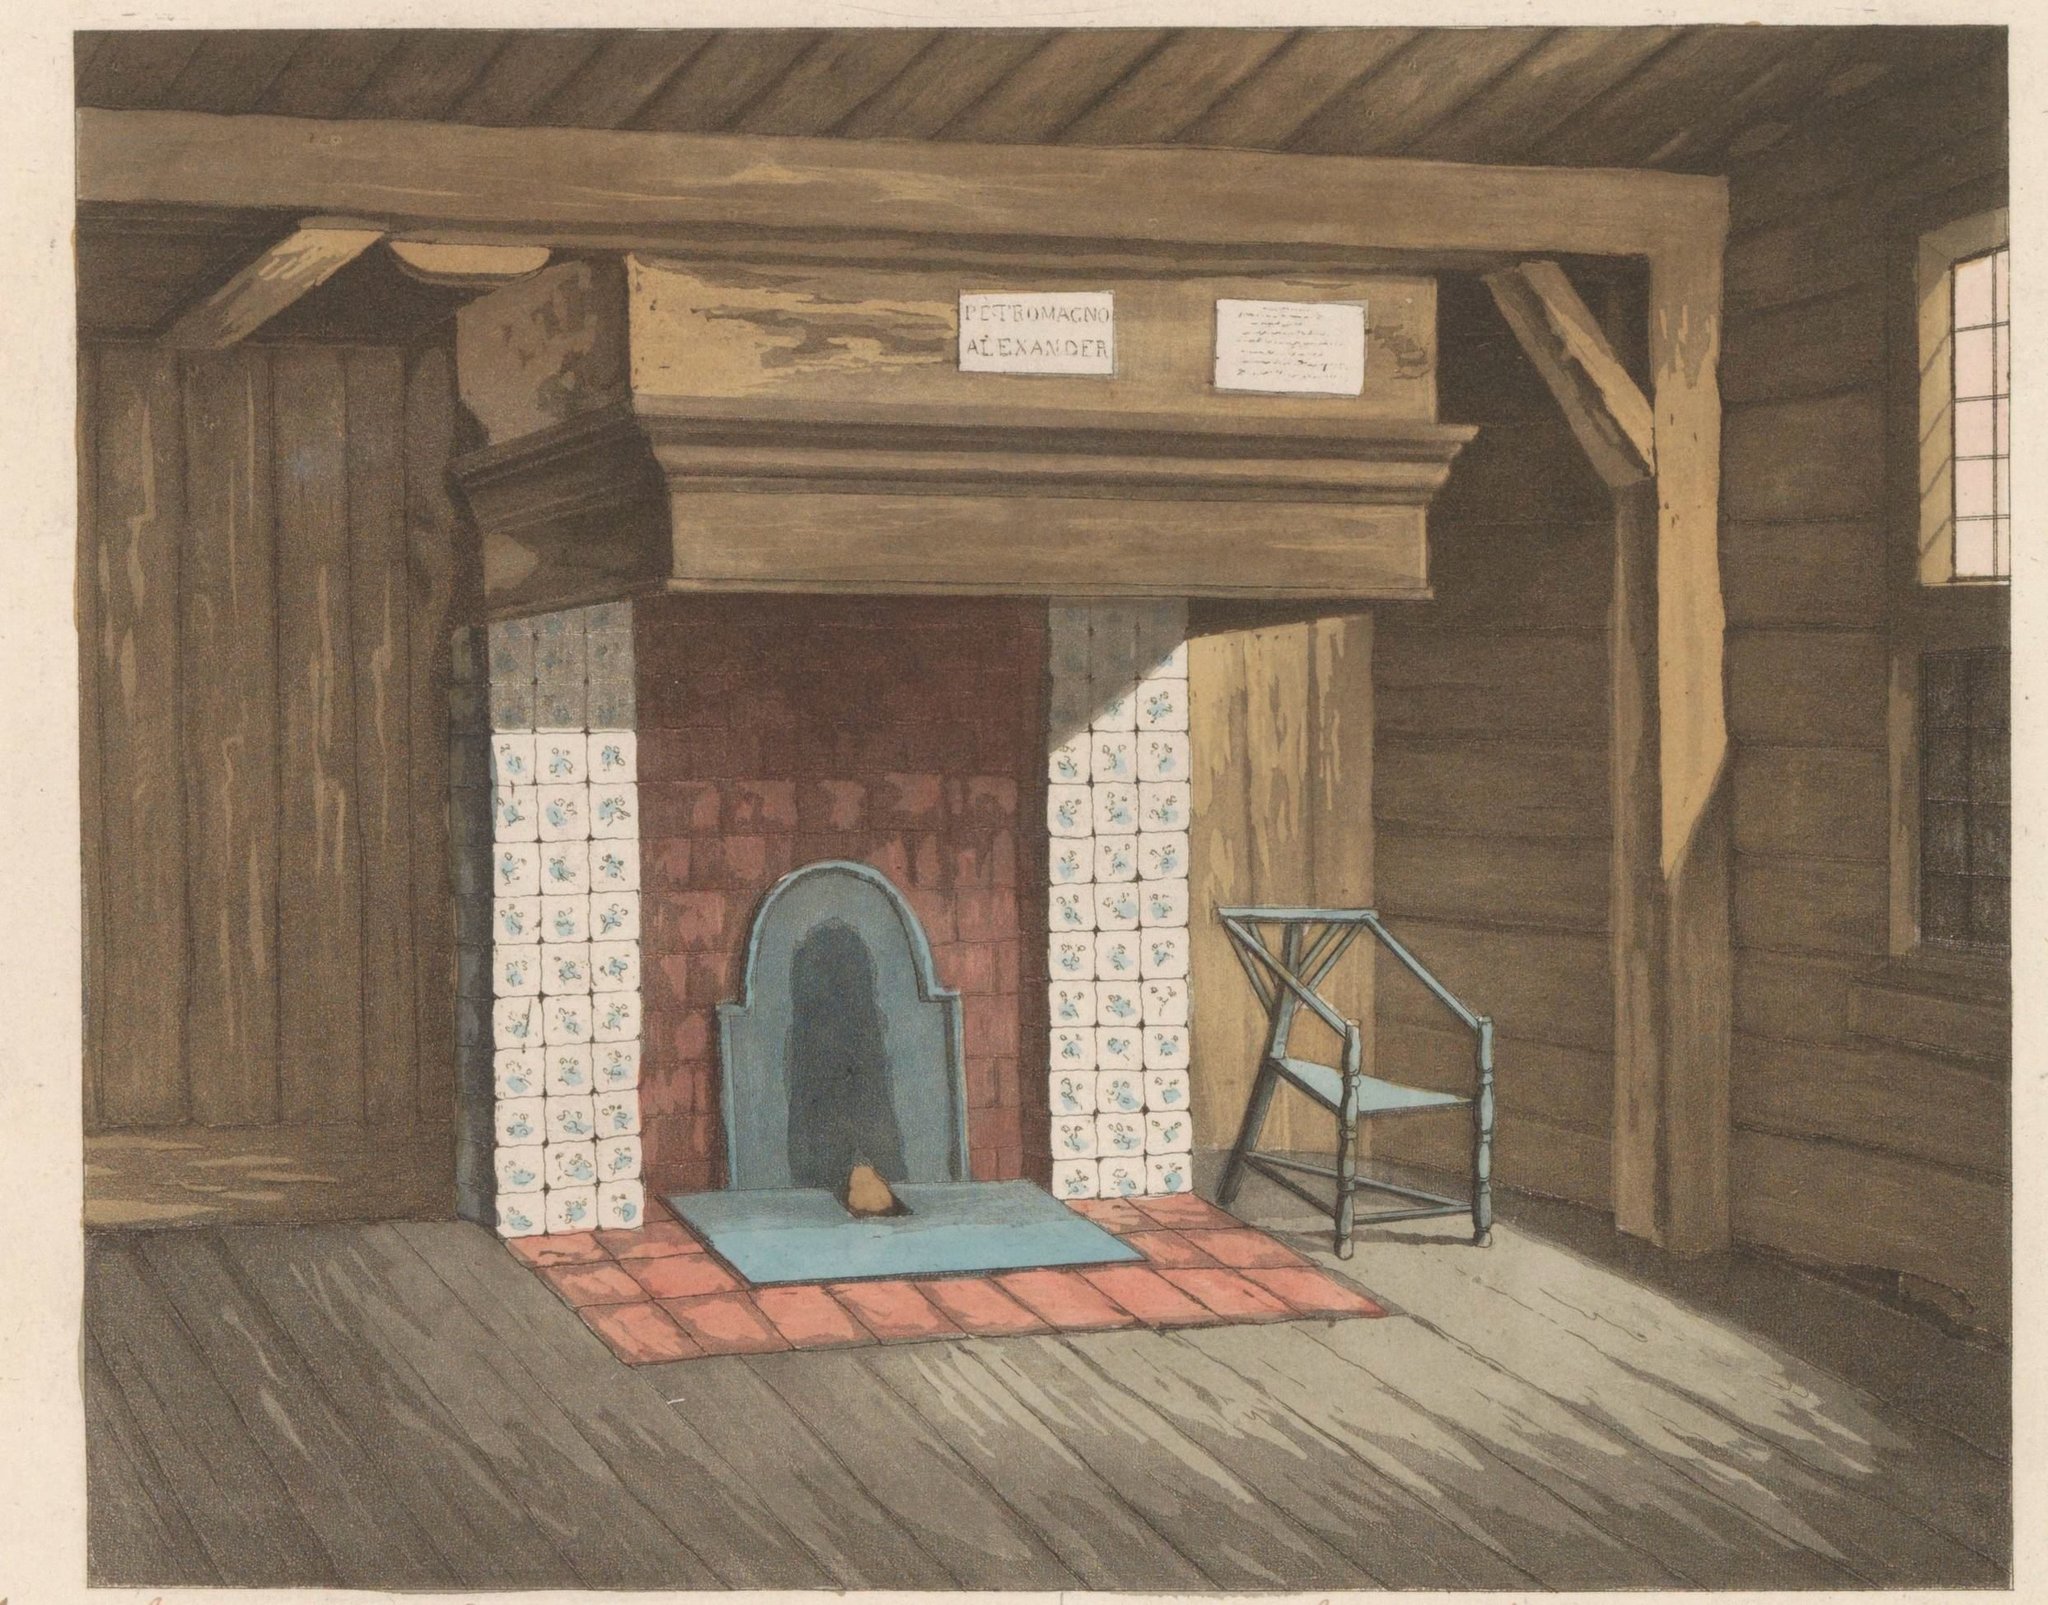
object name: print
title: Het huisje bewoond door Czaar peeter de groten te Zaandam in het Jaar 1697 (...) - La maisonnette habitée par le Czar pierre le grand à Zaandam (...)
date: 1824-1825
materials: paper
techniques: aquatint, etching, hand coloring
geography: amsterdam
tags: peter i de grote (tsaar van rusland)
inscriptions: inscription: ‘chez E: Maaskamp à Amsterdam’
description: Interieur van Tsaar Peterhuisje te Zaandam naar de scheepstimmerwerf, ca. 1824-1825. Onderdeel van een plaatwerk uit ca. 1824-1825 met 74 (ongenummerde) platen van de belangrijkste topografische gezichten en verschillende zeden en gewoonten in het Verenigd Koninkrijk der Nederlanden.